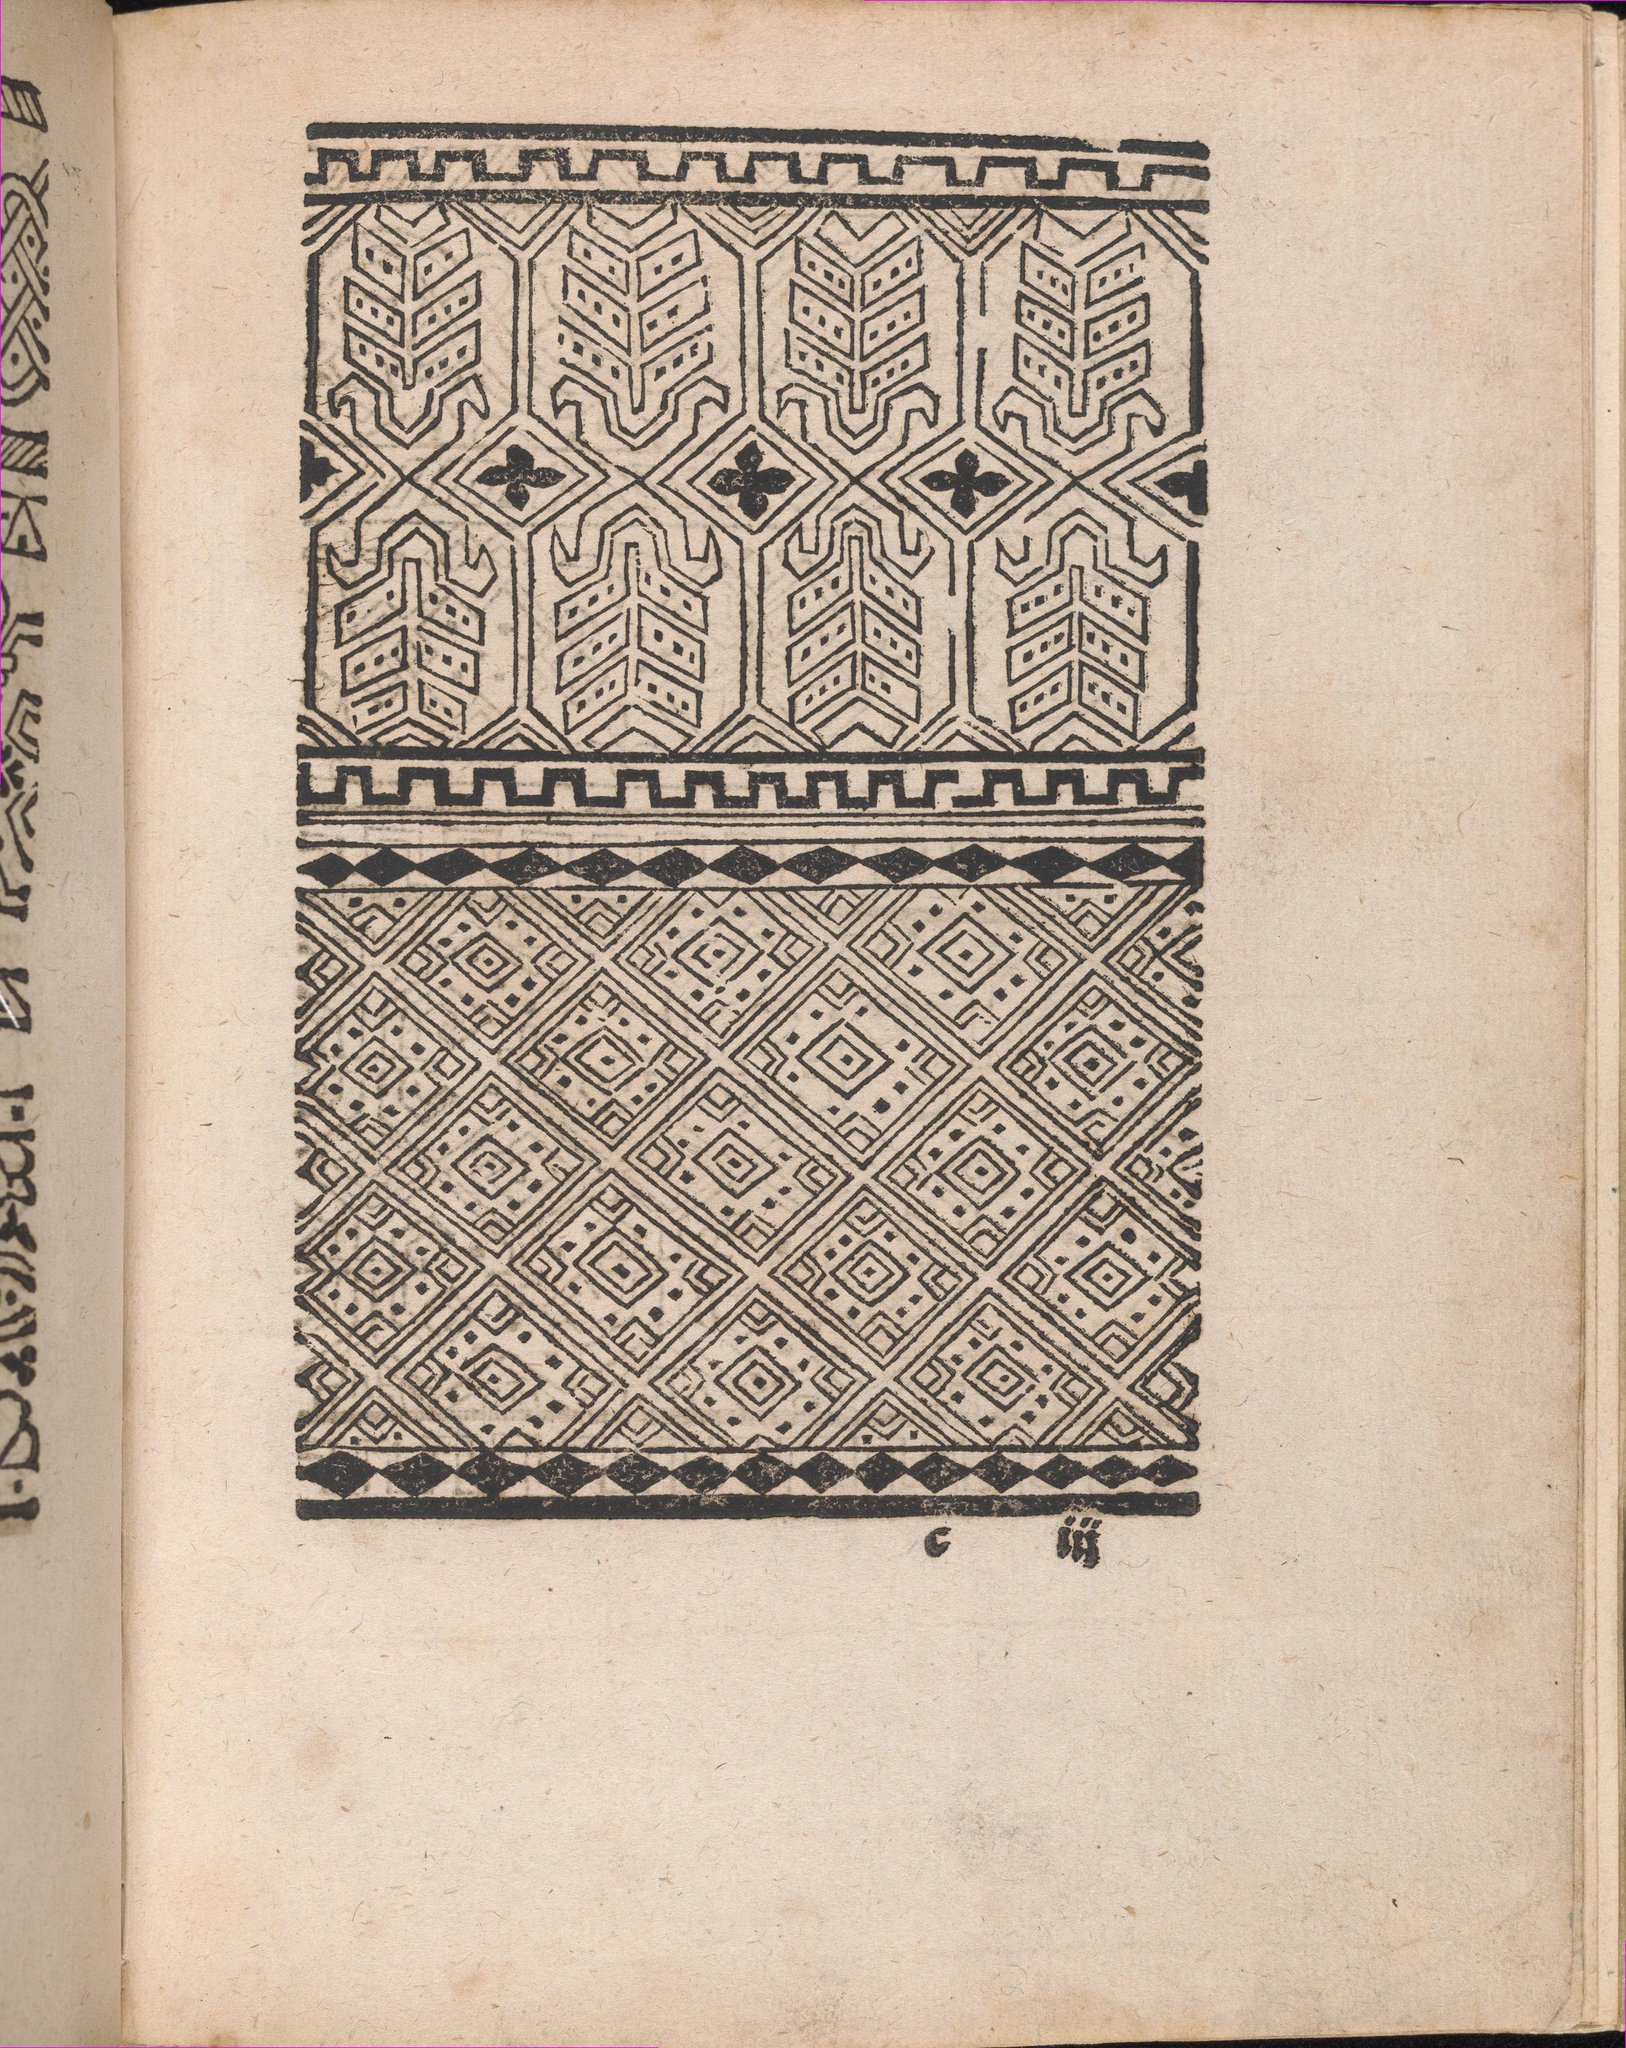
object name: book print ornament architecture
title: Modelbuch aller Art Nehens vn Stickens (Page 11r)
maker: christian egenolff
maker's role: publisher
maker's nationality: german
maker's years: 1502-1555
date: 1535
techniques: woodcut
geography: germany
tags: ornament